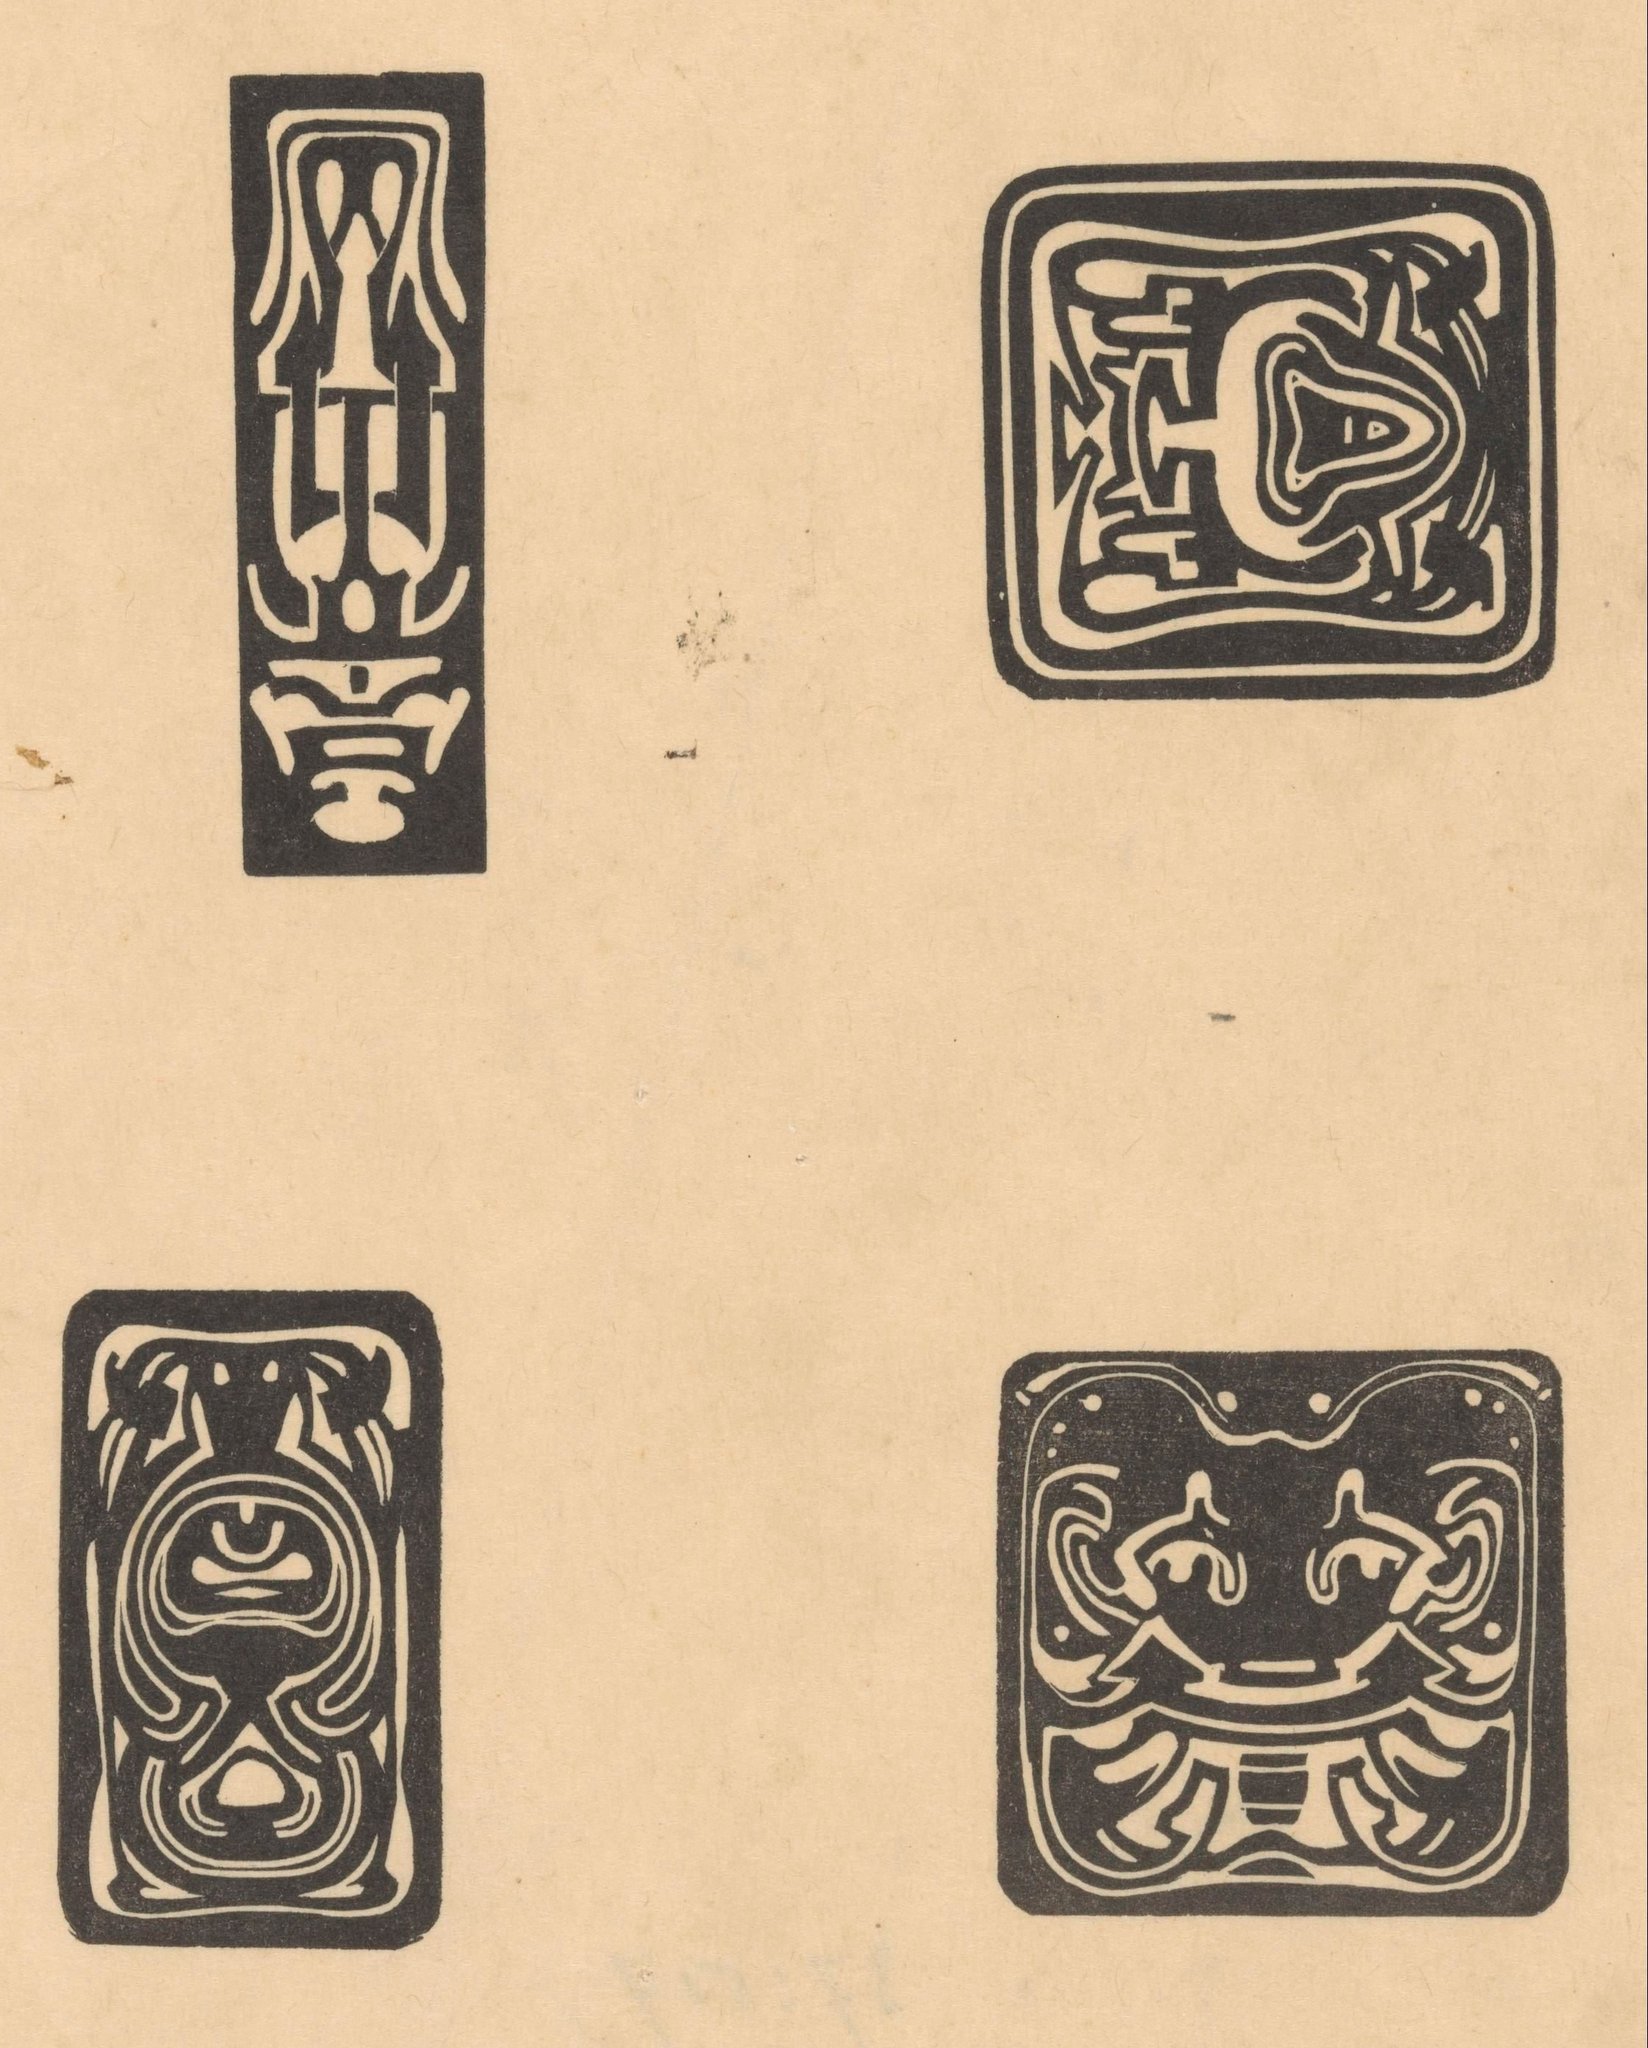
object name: print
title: Vier ex librissen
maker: johannes josephus aarts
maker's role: draughtsman, print maker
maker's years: 1871-1934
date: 1881-1934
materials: paper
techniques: woodcut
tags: ex-libris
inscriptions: collector's mark: Lugt 2228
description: Vier ex librissen met abstracte, symmetrische vormen.